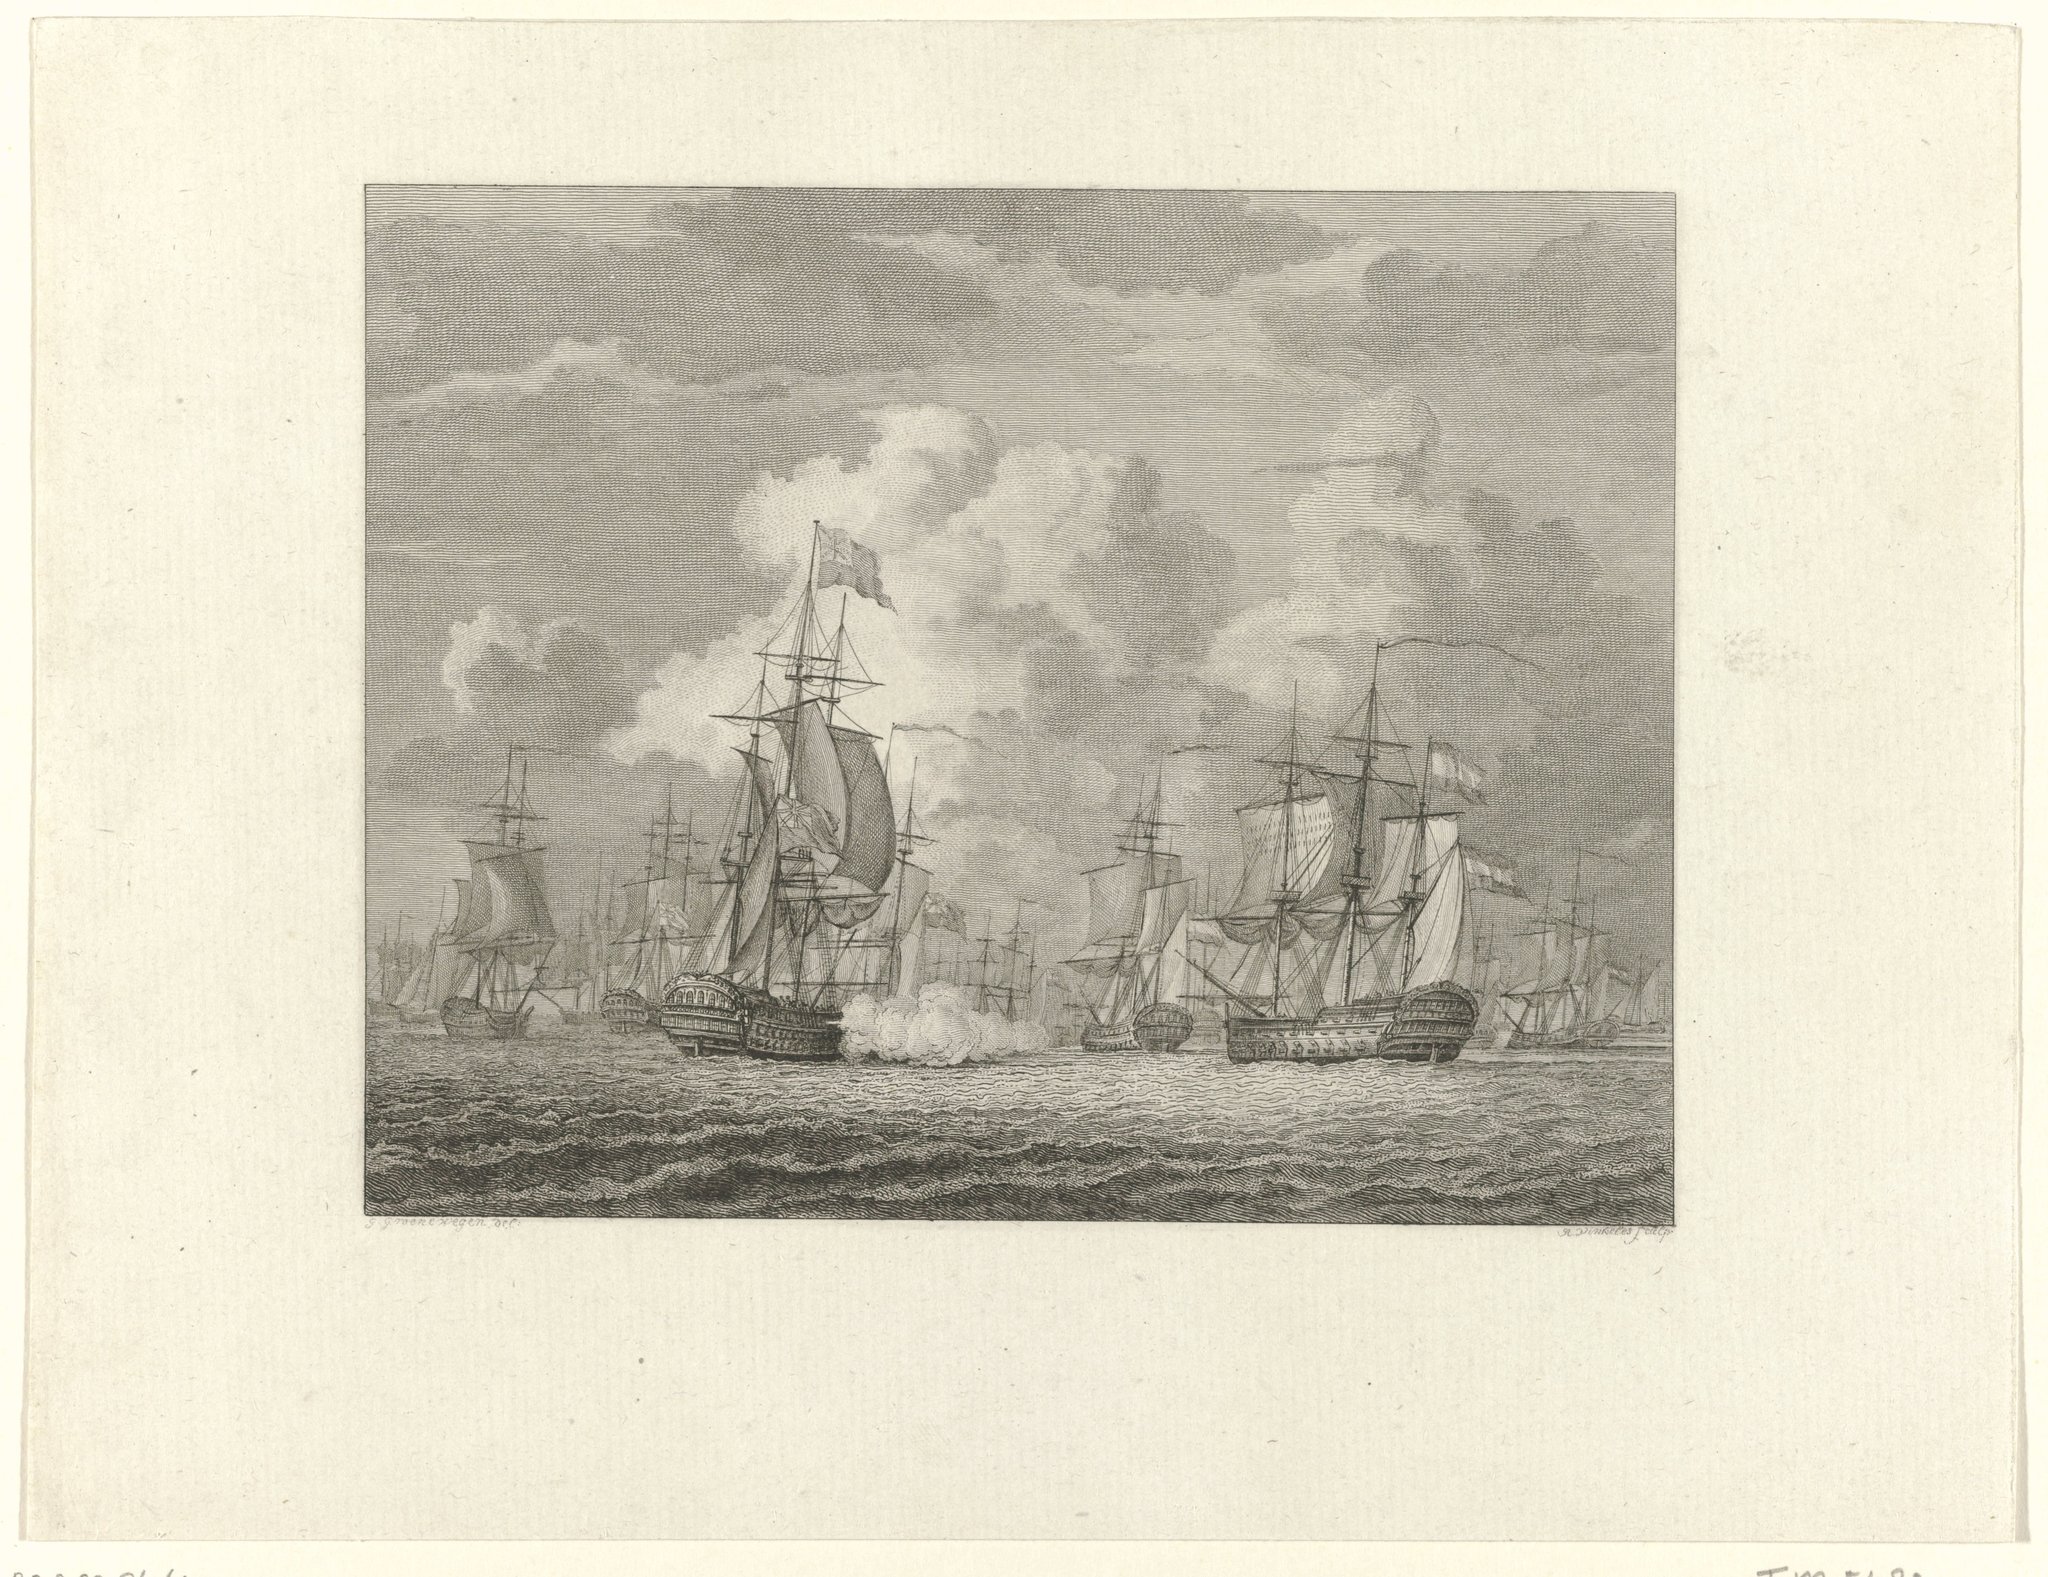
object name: print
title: Zeeslag bij Kamperduin, 1797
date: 1797-1798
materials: paper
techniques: engraving, etching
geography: netherlands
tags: paris, jan willem de winter, battle (+ naval force), battle of camperdown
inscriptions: collector's mark: Lugt 2228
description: De Zeeslag bij Kamperduin op 11 oktober 1797 tussen de Bataafse vloot onder bevel van viceadmiraal Jan Willem de Winter en een Britse vloot onder admiraal Adam Duncan.